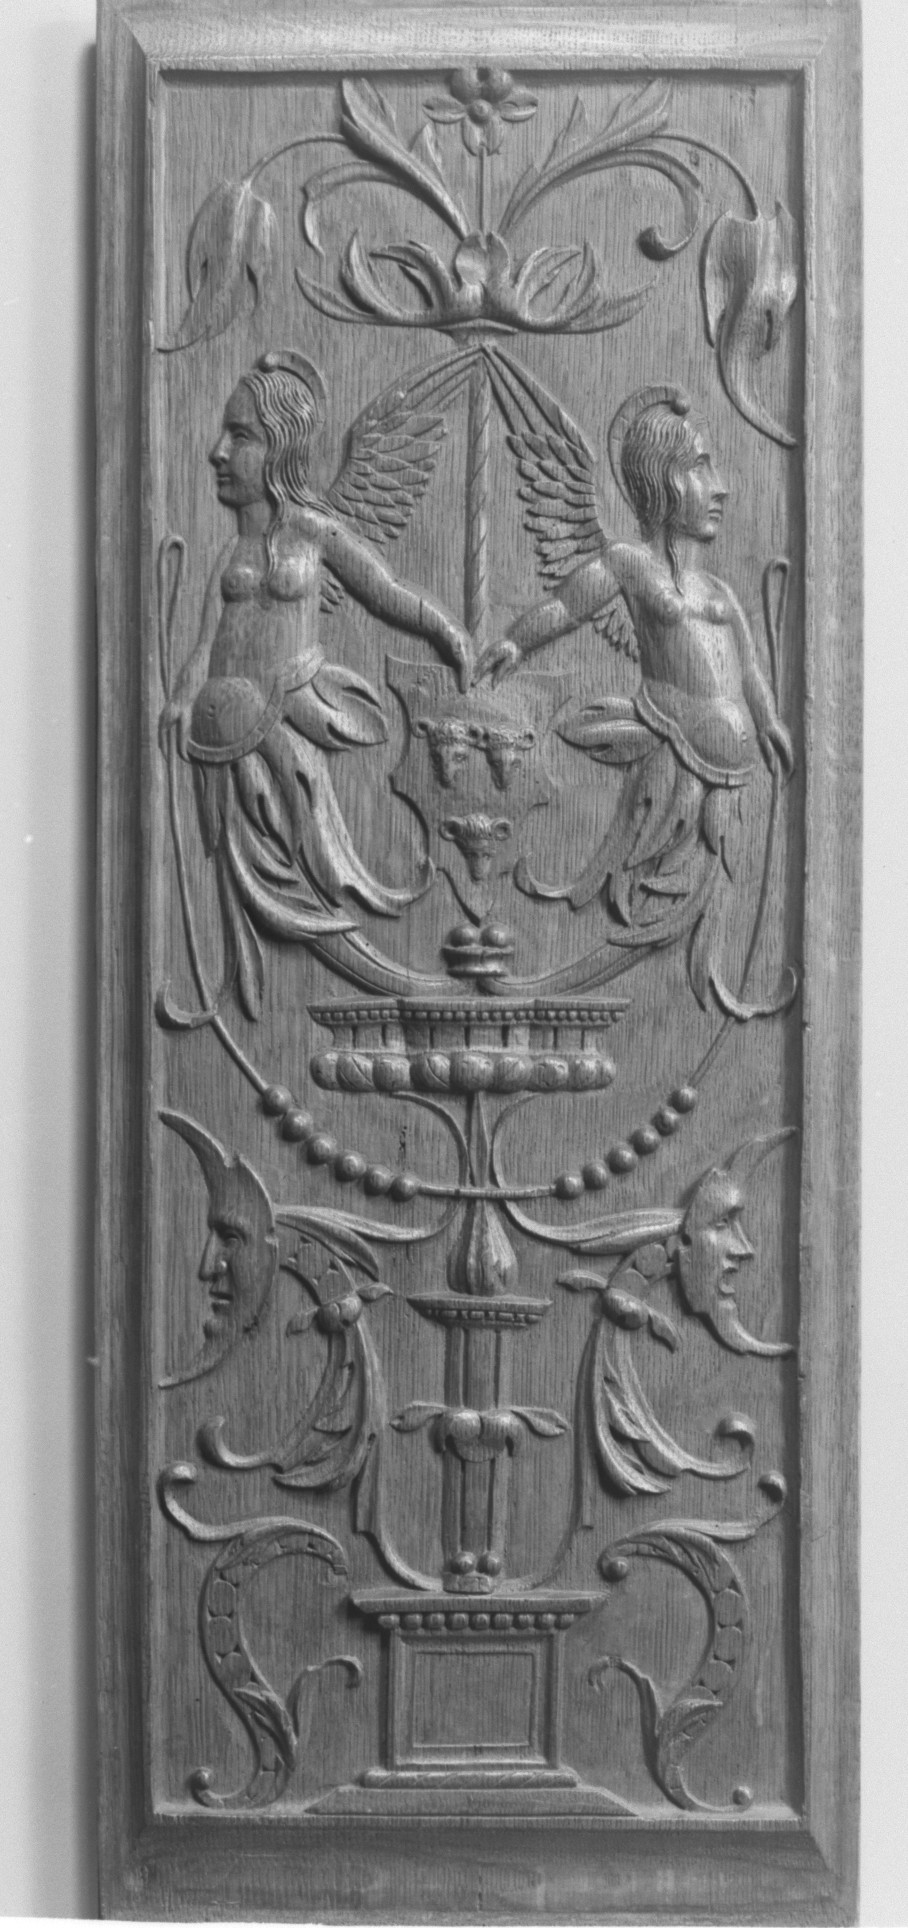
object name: panel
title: Panel (part of a set)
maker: nicolas castille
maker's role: maker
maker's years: 1503-1521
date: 1510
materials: wood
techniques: carving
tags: flowers,leaves,coat of arms